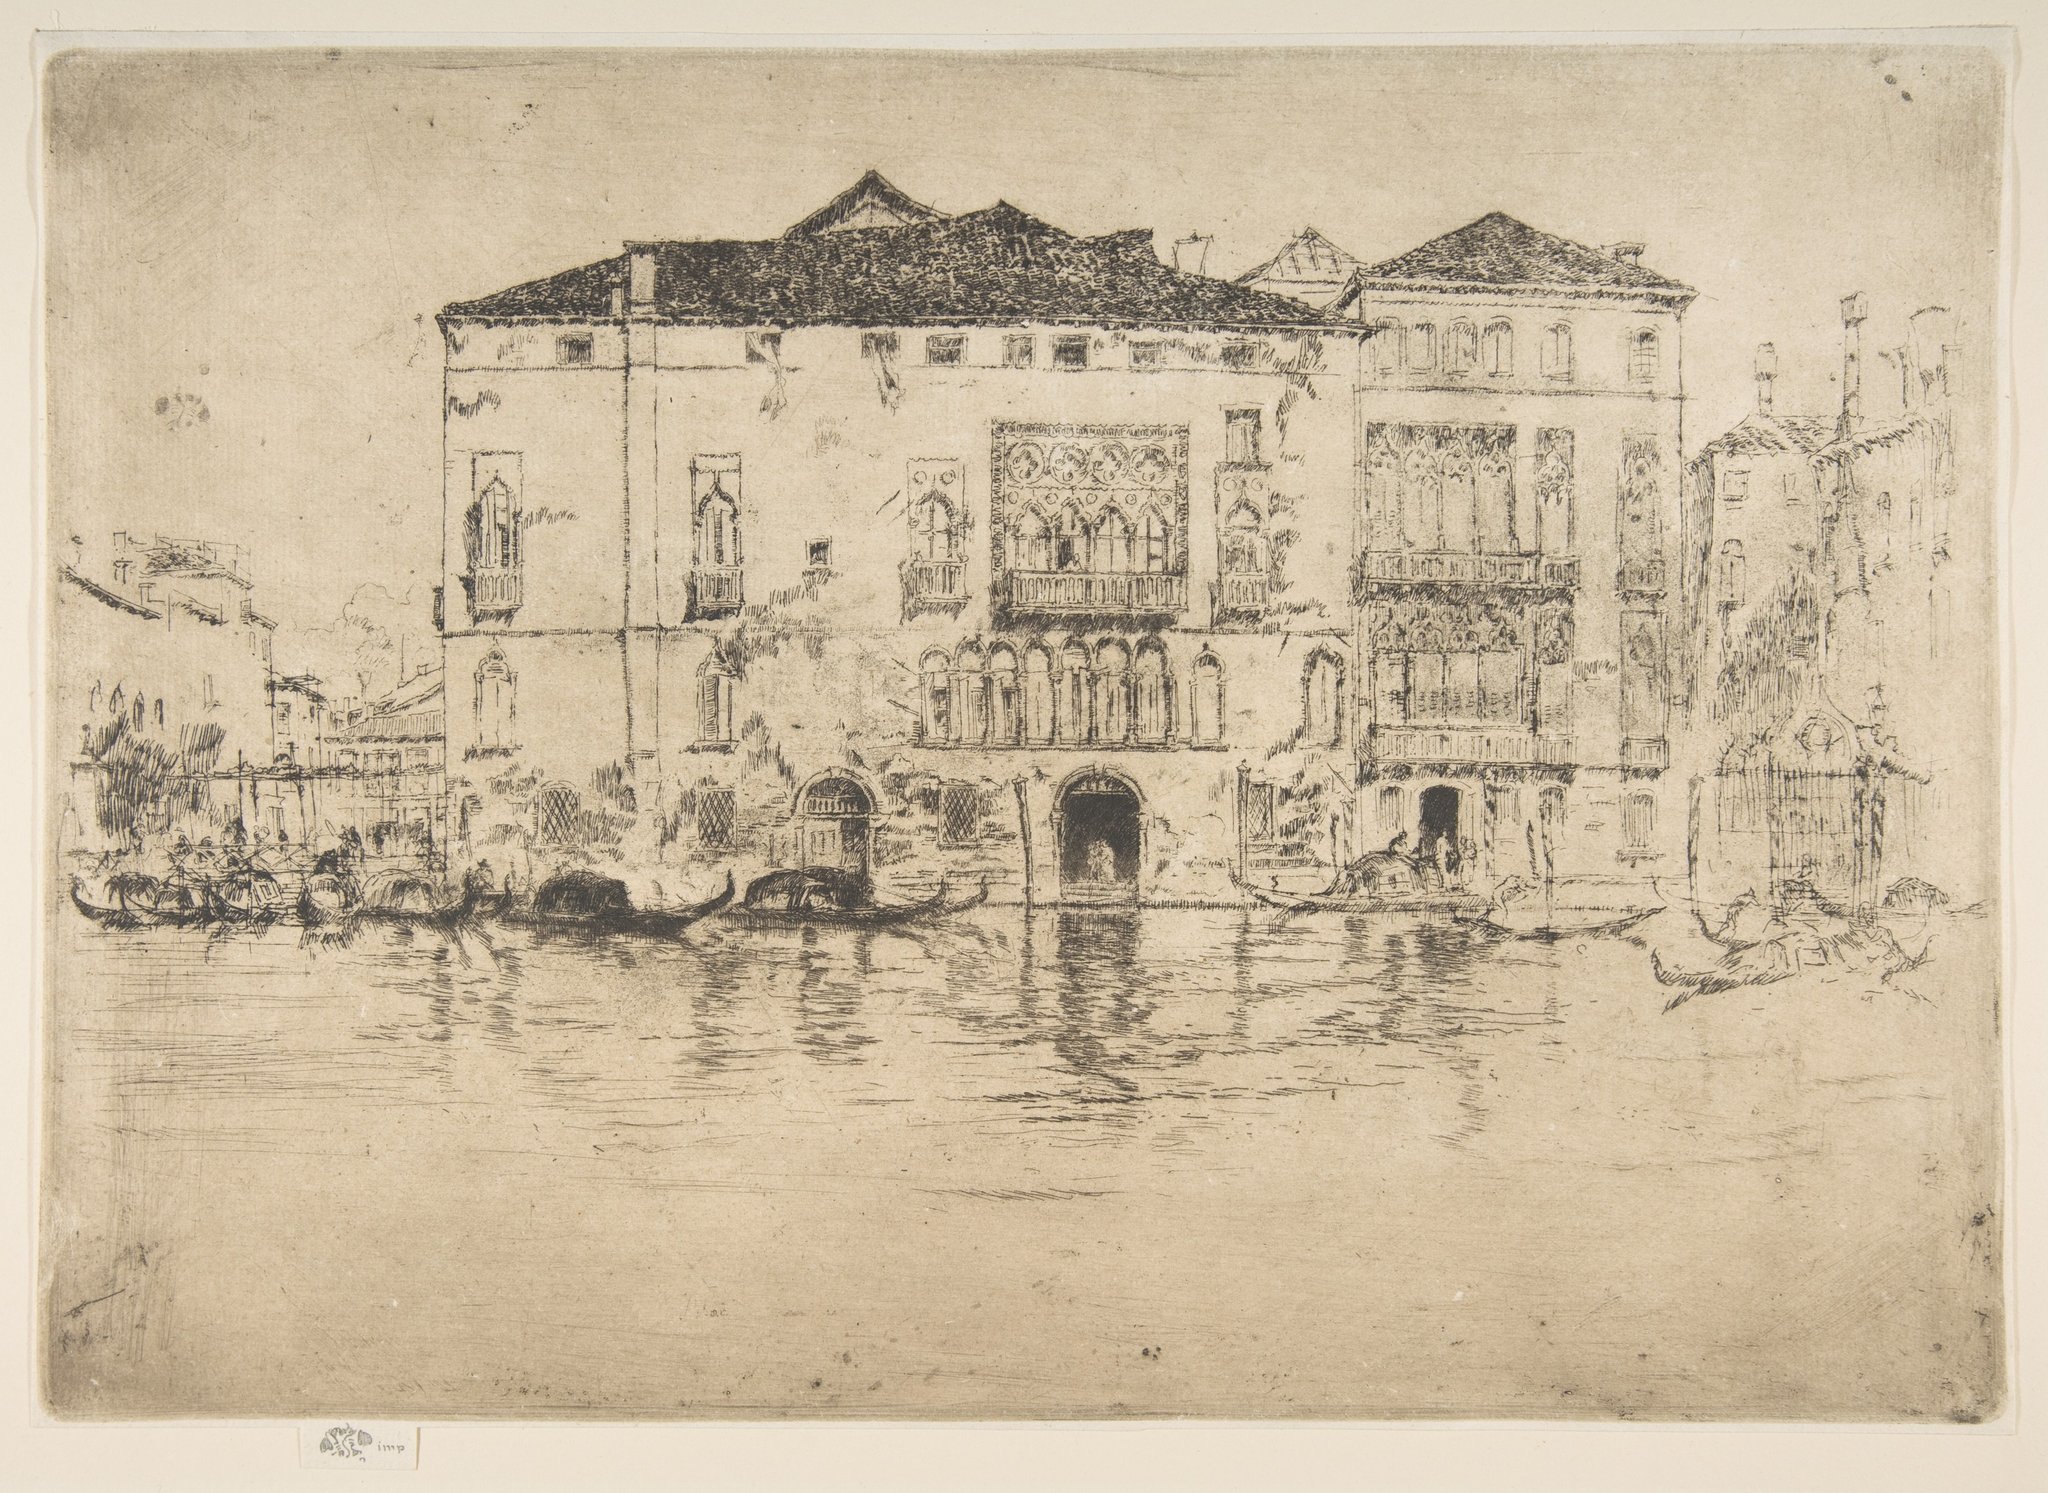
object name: print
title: The Palaces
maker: james mcneill whistler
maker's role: artist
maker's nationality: american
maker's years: 1834-1903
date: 1879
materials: ink, paper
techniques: drypoint, etching, printing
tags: palaces,boats,venice